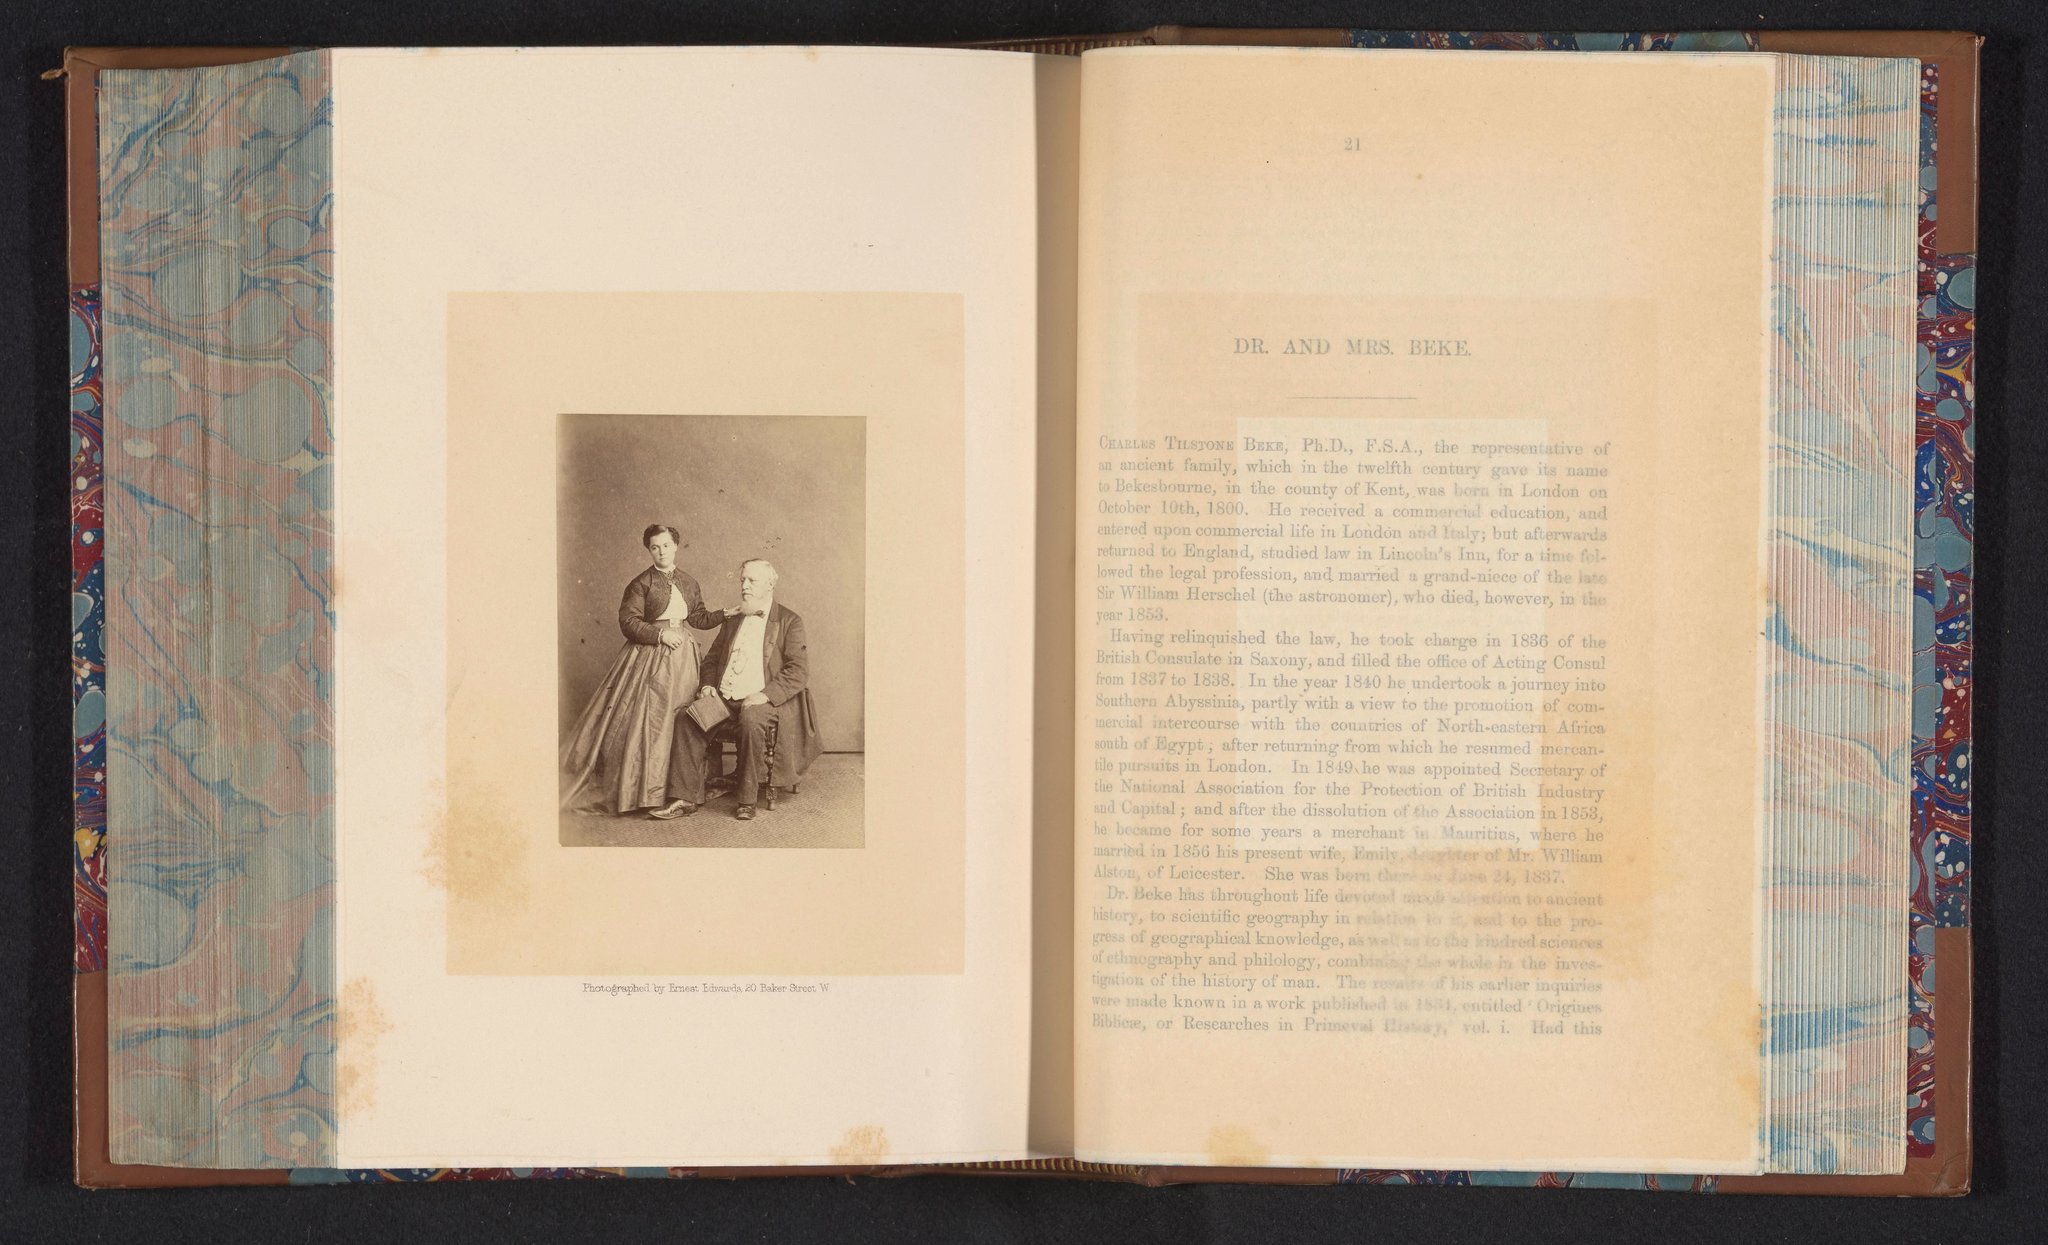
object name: page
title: Portret van Charles Tilstone Beke en zijn vrouw Emily Beke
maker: ernest edwards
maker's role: fotograaf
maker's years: 1837-1903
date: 1853-1867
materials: photographic support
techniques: albumen print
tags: traveler, geography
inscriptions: name: ‘Photographed by Ernest Edwards, 20, Baker Street. W.’